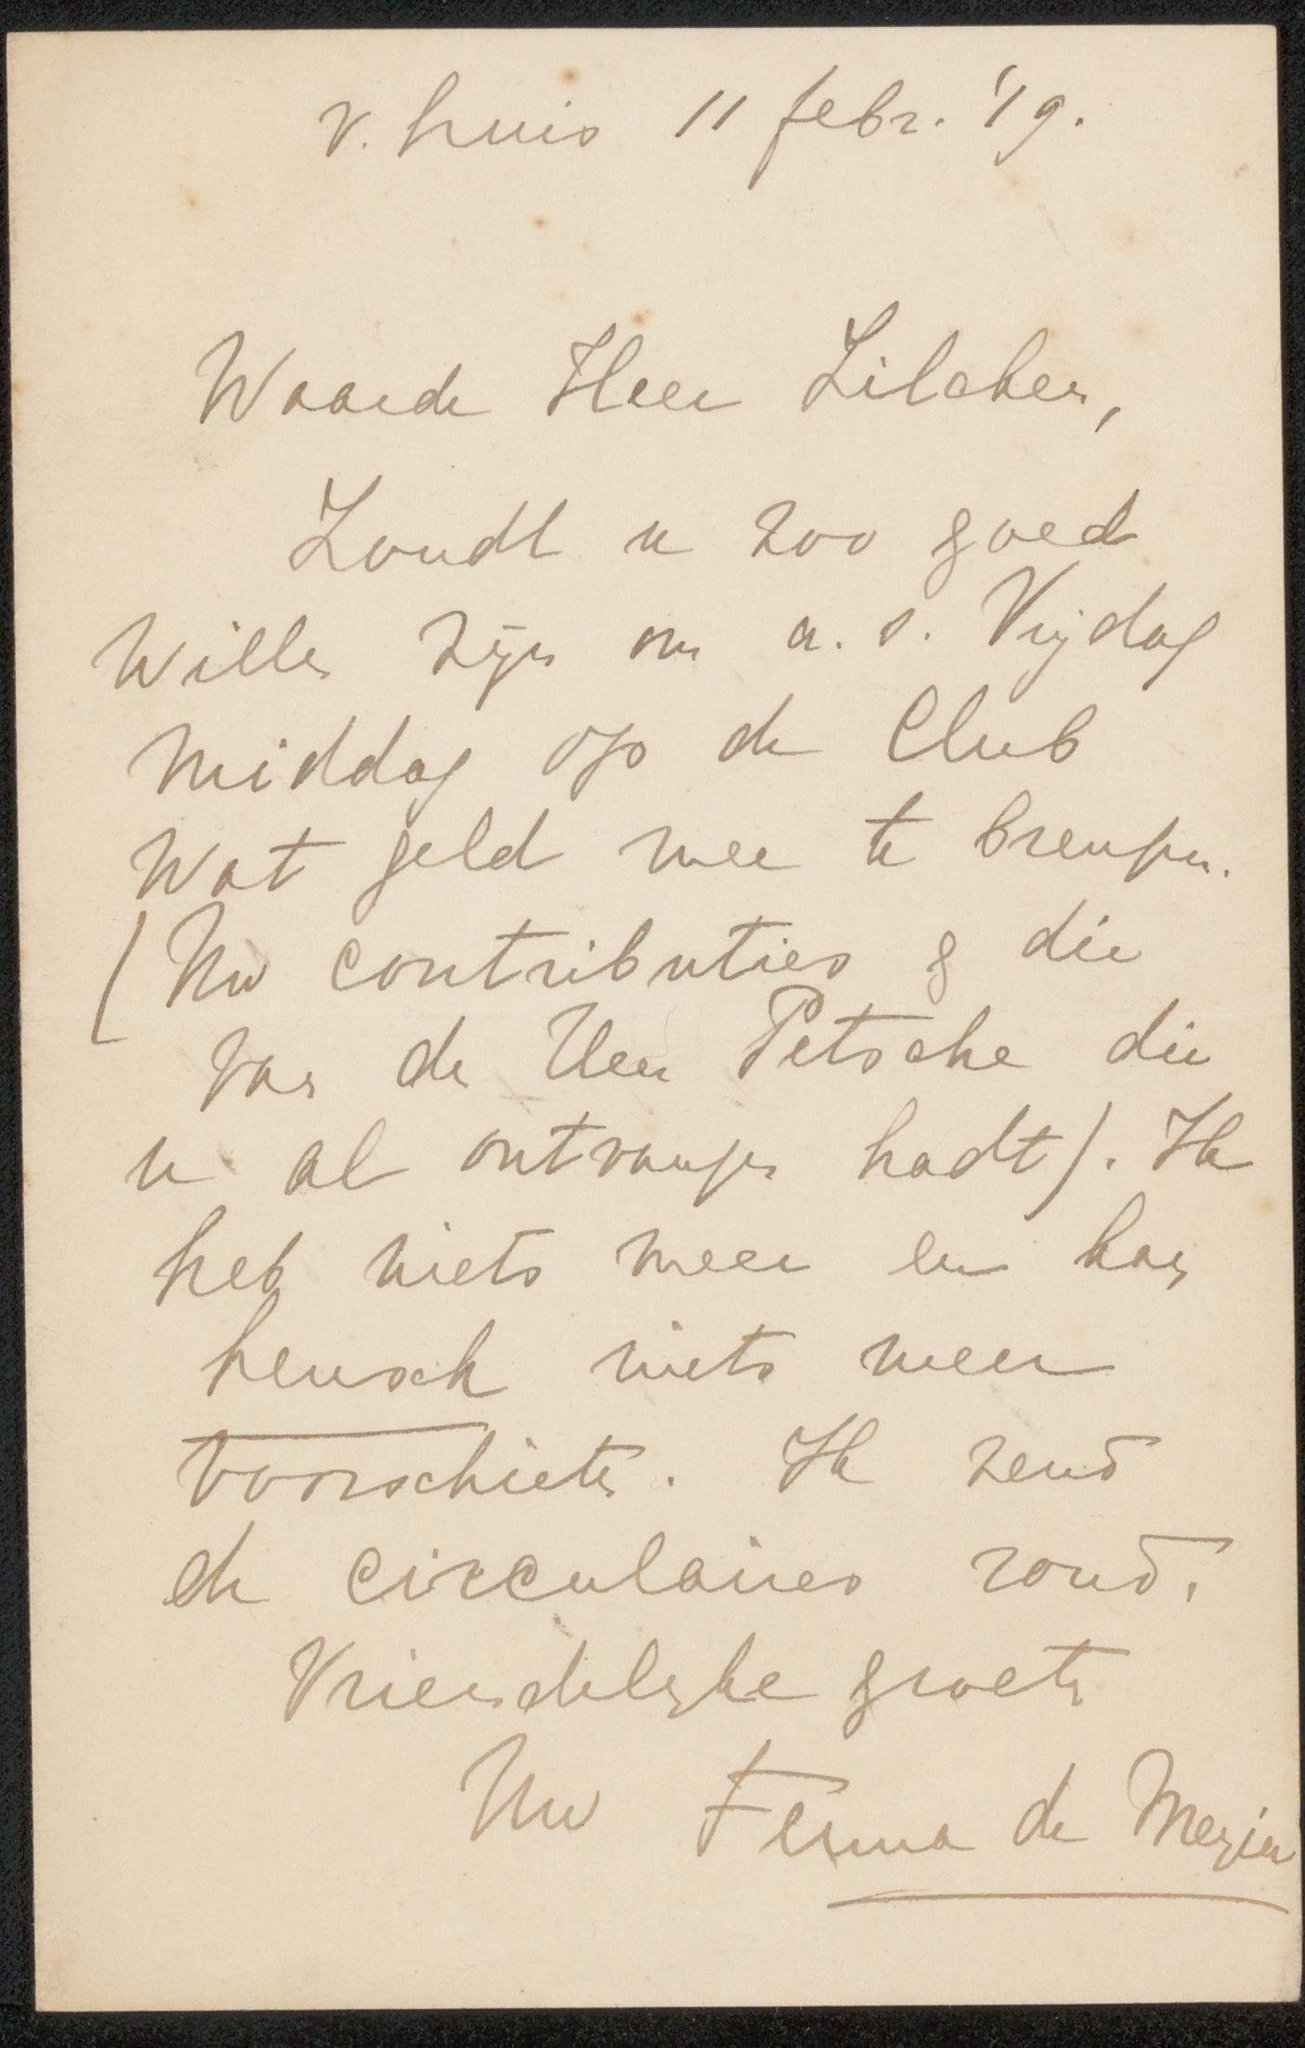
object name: letter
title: Brief aan Philip Zilcken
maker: fenna de meyier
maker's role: onderwijzer, schrijver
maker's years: 1874-1943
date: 1919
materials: ink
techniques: pen, writing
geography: the hague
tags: the hague, painter, draughtsman, philip zilcken, money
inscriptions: collector's mark: ‘RPK’